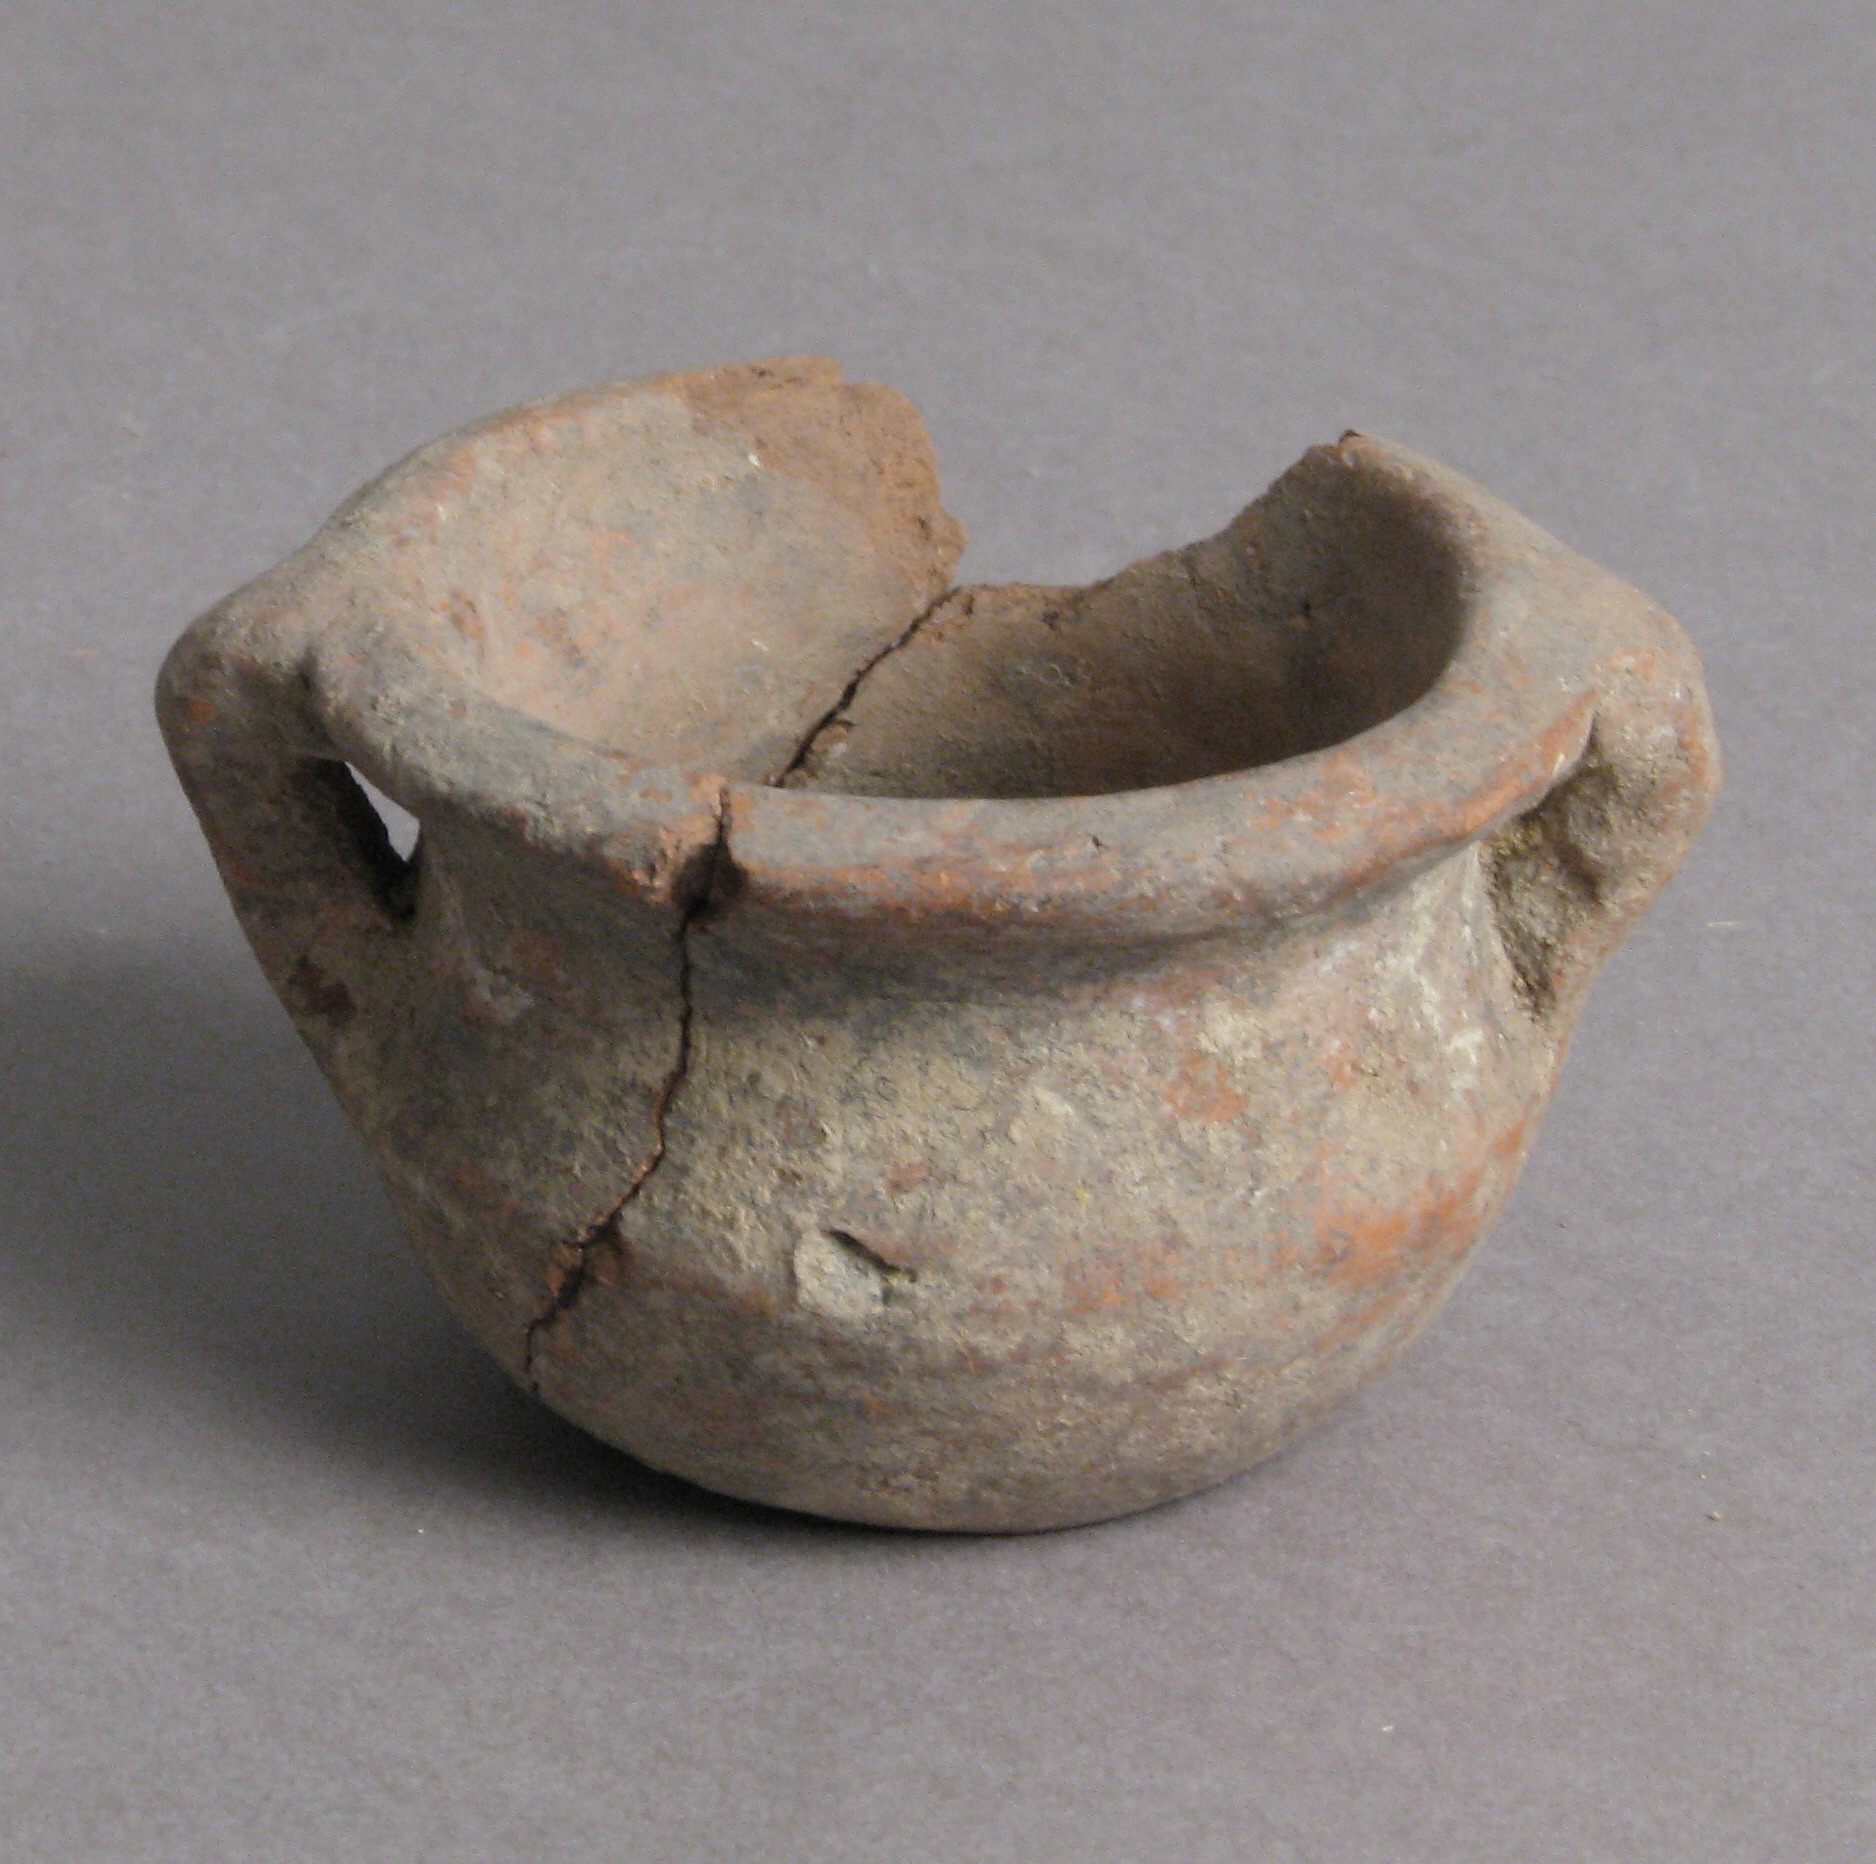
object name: pot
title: Two Handled Pot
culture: coptic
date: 301-700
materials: earthenware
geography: egypt